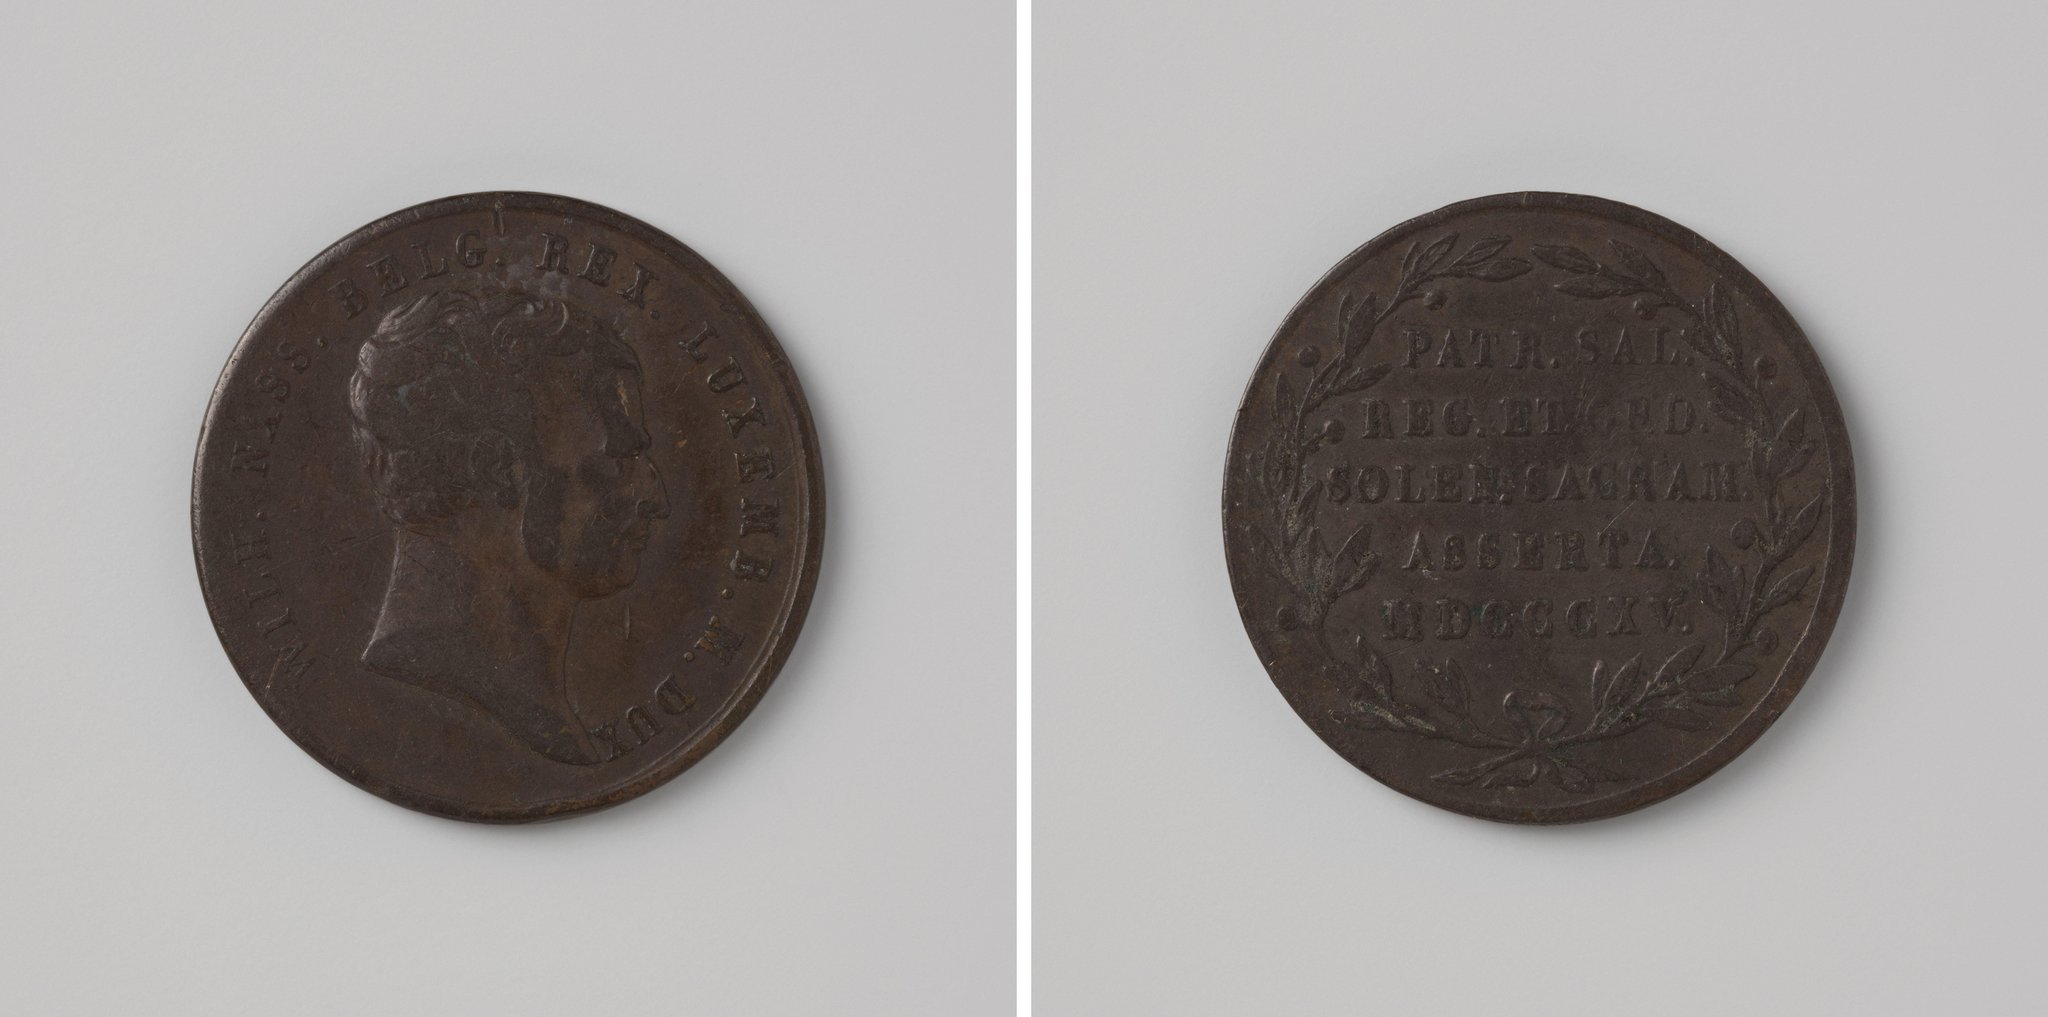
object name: strooipenning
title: Inhuldiging van Willem I Frederik als koning der Nederlanden te Brussel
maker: pierre wautier van de goor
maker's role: medailleur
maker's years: 1783-1851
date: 1815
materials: bronze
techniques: striking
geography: brussels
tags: william i of the netherlands, brussels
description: Bronzen penning. Voorzijde: borststuk man binnen omschrift. Keerzijde: opschrift binnen olijfkrans